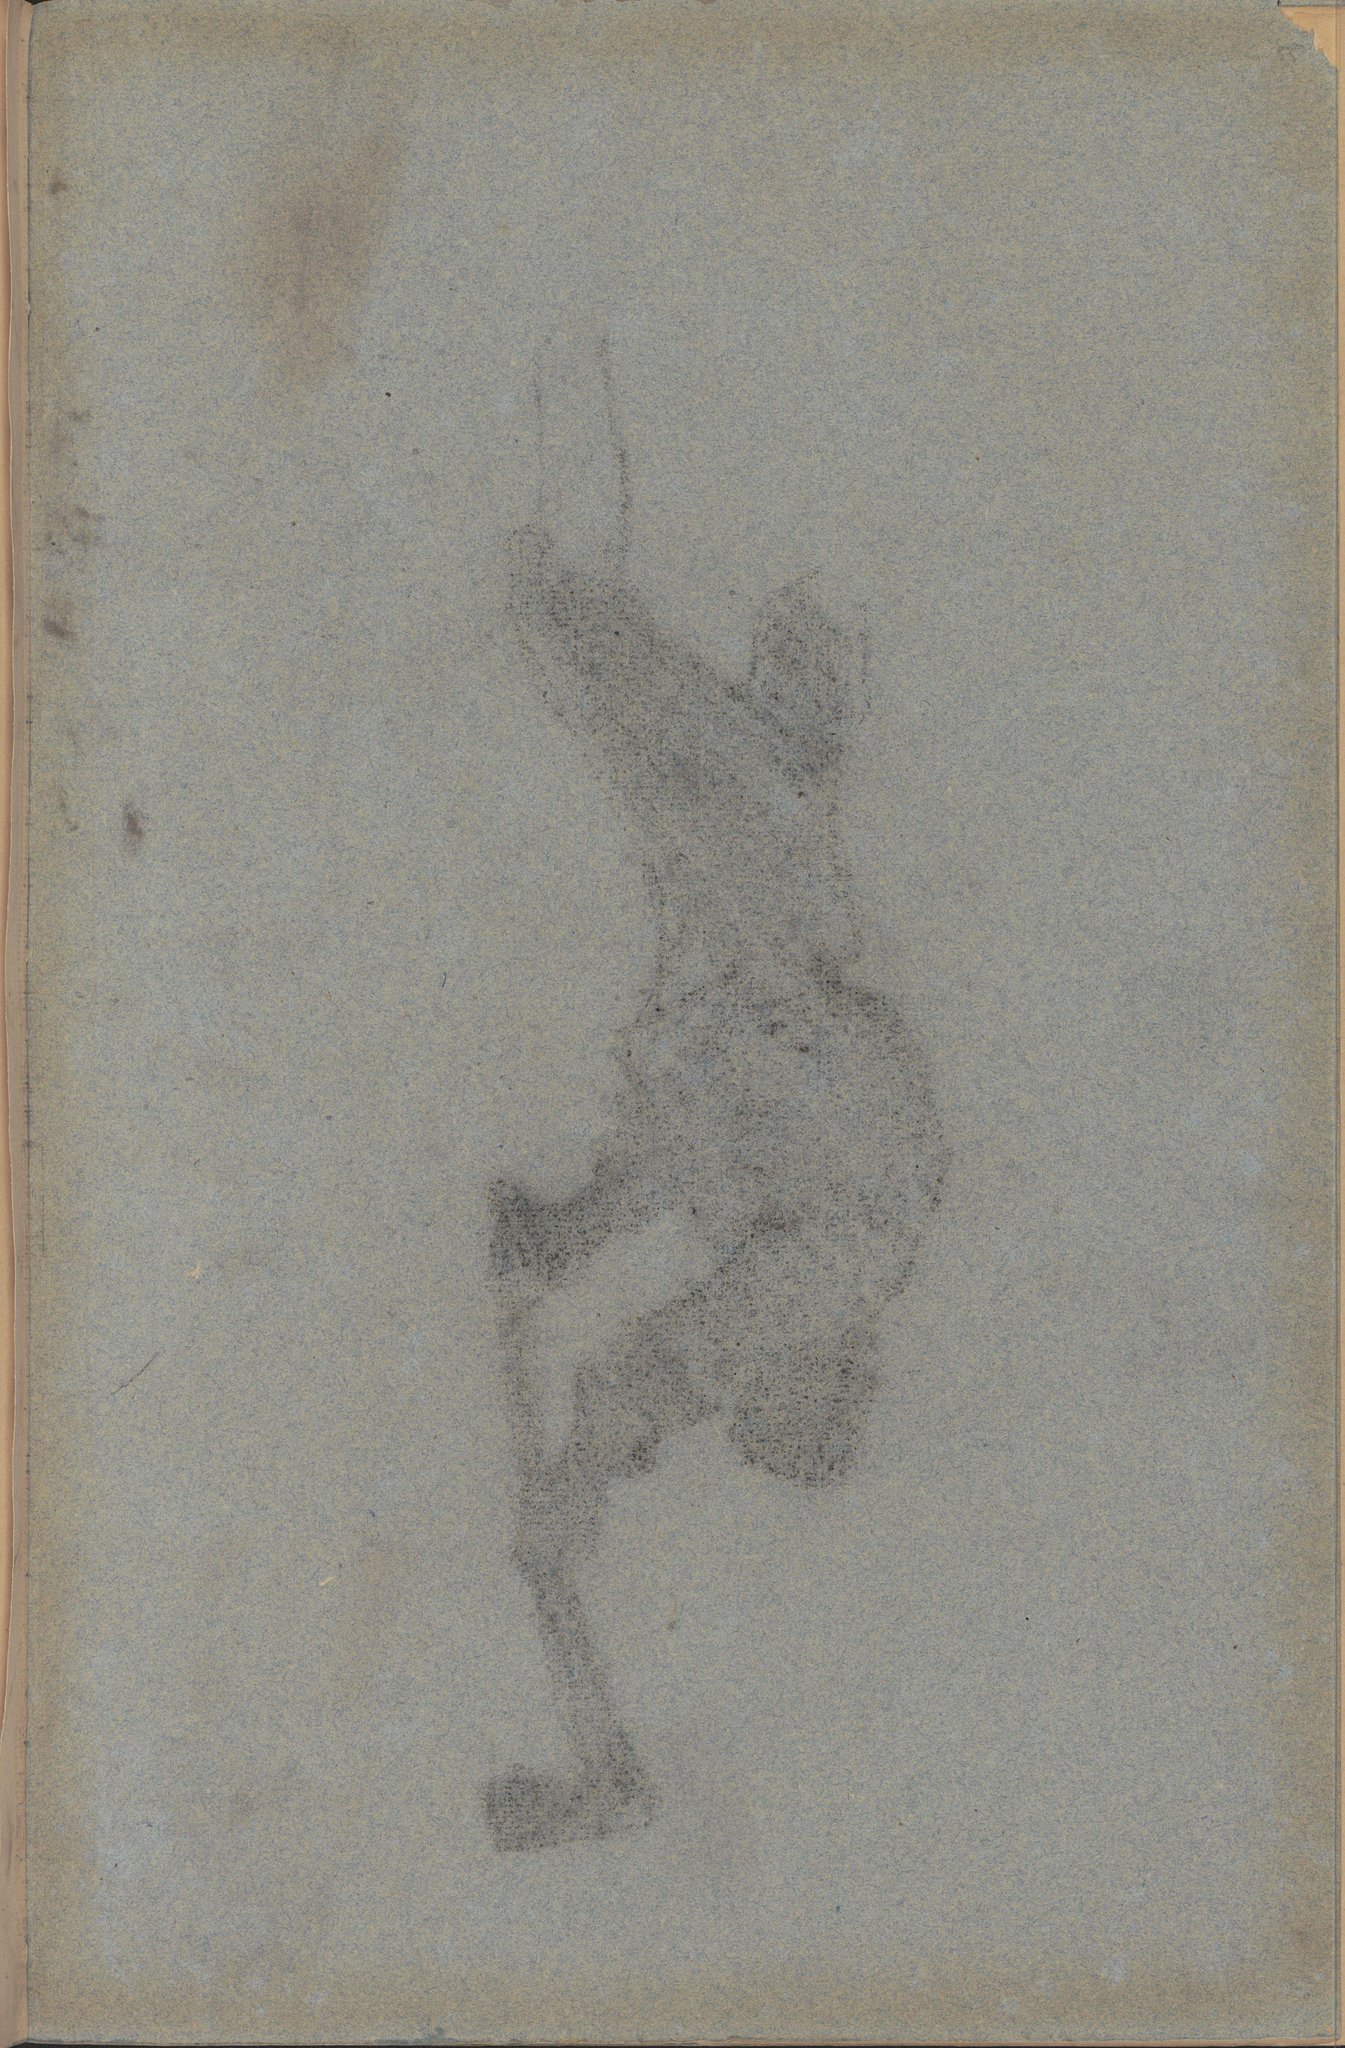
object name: sketchbook leaf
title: Abklatsch van de krijttekening op pagina 54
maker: willem witsen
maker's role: draughtsman, painter, print maker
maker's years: 1860-1923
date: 1884-1887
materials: paper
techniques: printmaking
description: Pagina 55 uit een schetsboek met 38 bladen.